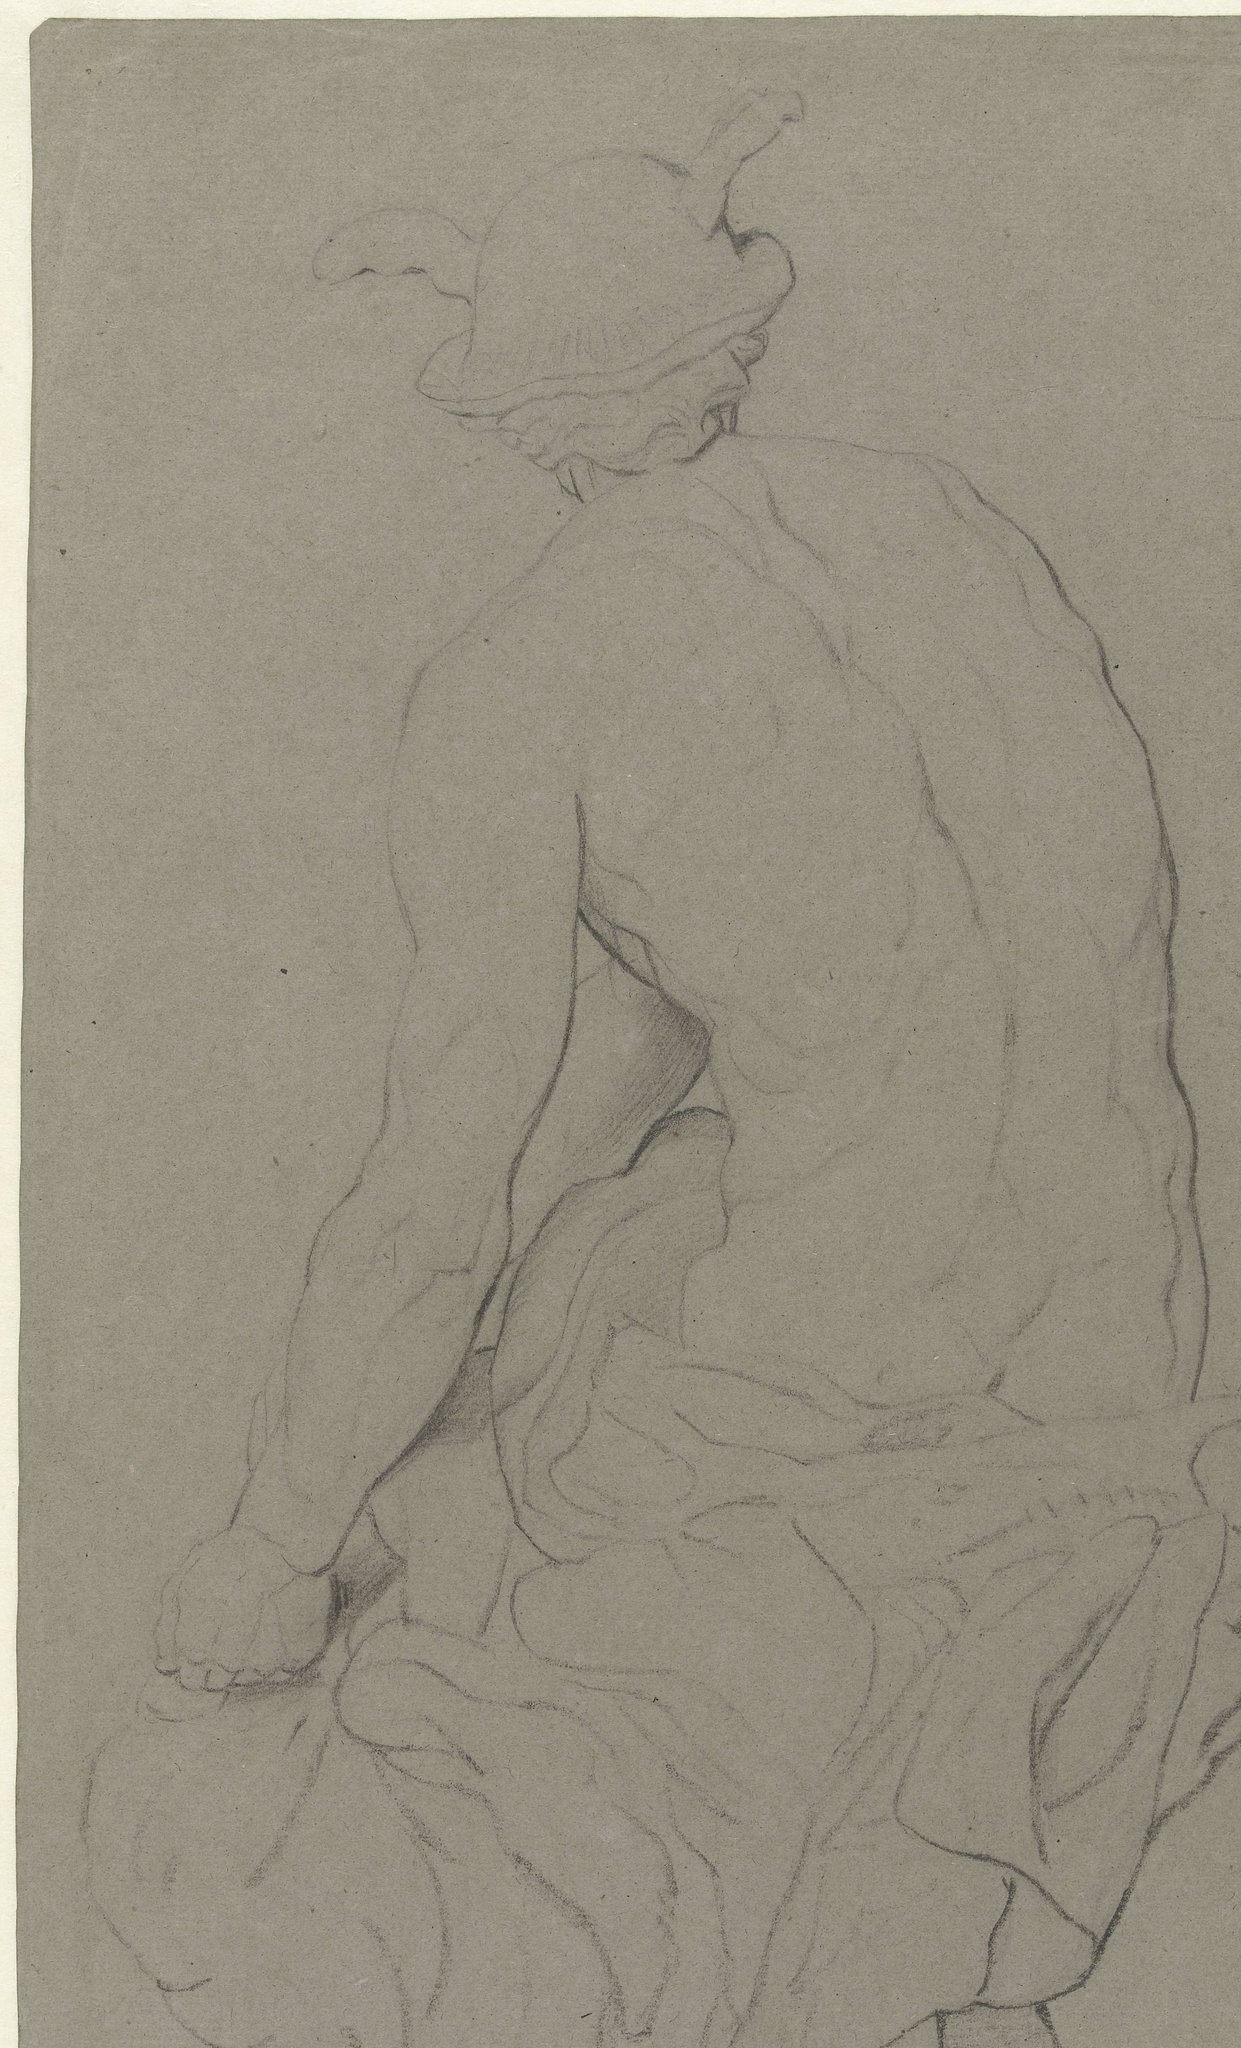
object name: drawing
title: Beeld van een zittende, sandalen bindende Mercurius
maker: jordanus hoorn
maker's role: draughtsman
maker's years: 1753-1833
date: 1775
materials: chalk, paper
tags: (story of) mercury (hermes), piece of sculpture, reproduction of a piece of sculpture